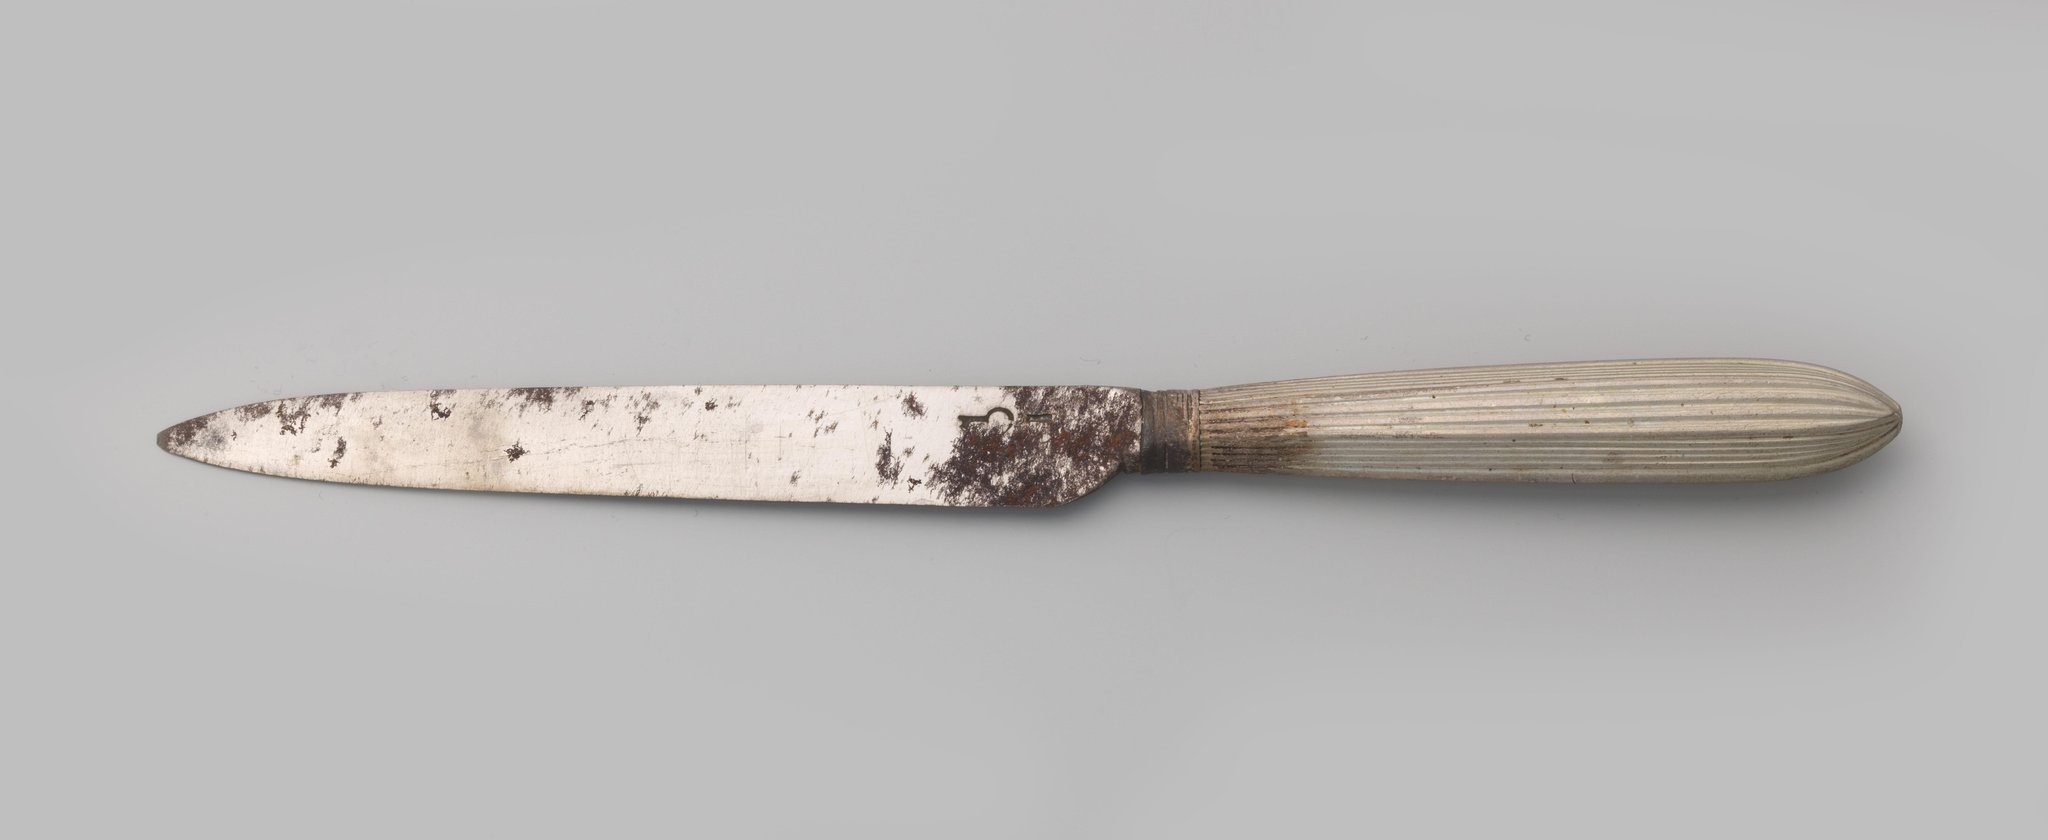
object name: knife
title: Mes met spits toelopend overlangs gegroefd heft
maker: Anonymous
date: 1800-1900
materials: silver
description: Mes van zilver met overlangs gegroefd spits toelopend heft.